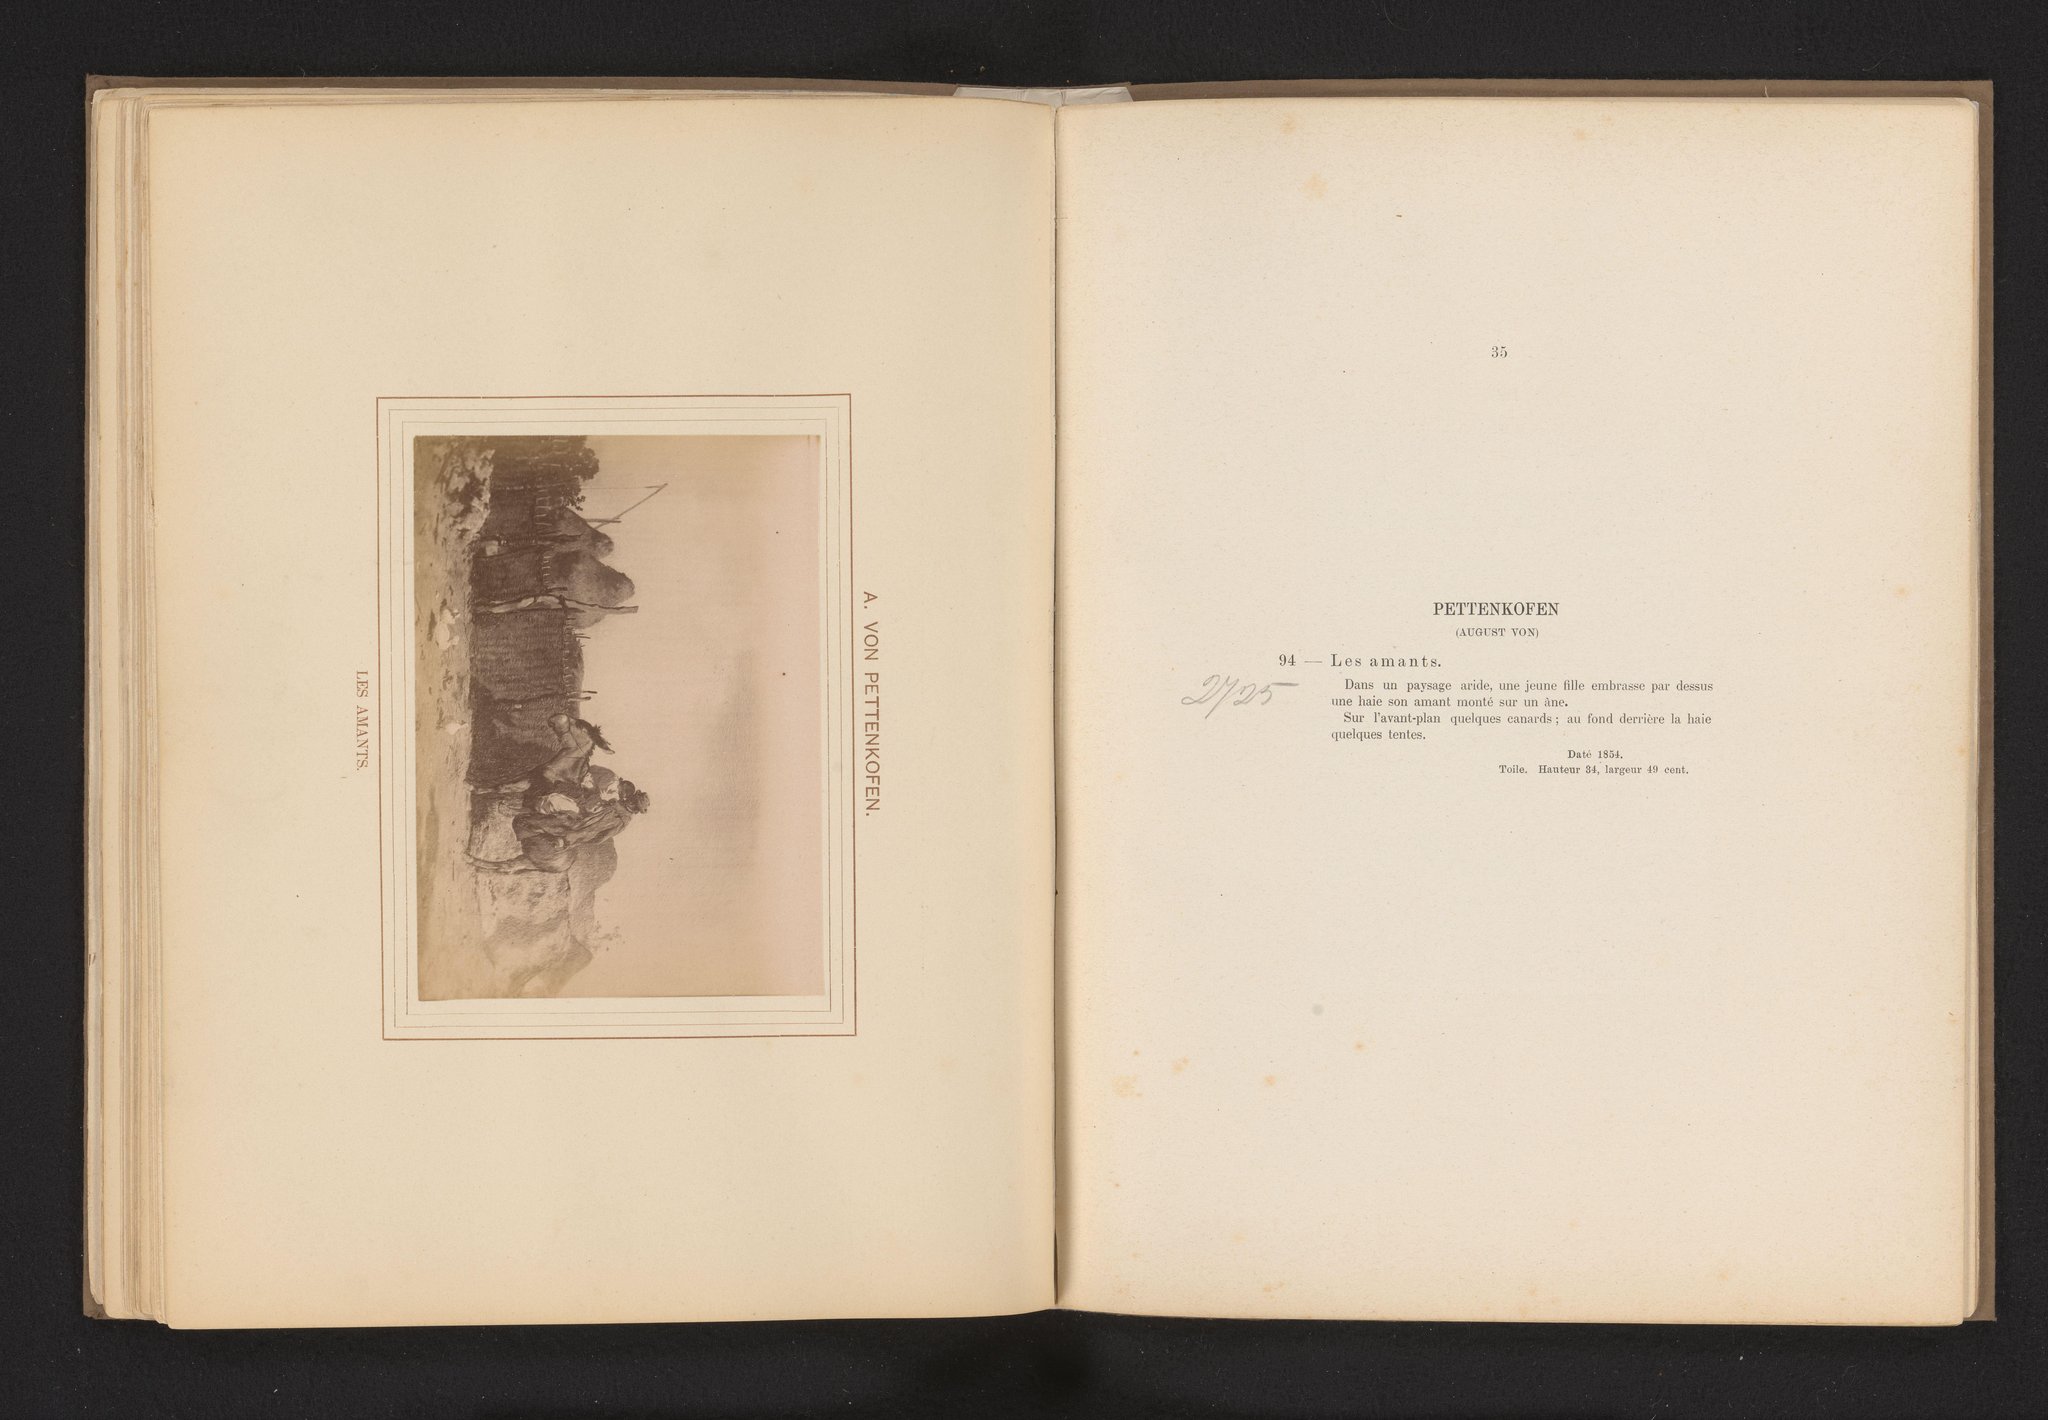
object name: page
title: Les amants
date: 1878-1883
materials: paper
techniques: albumen print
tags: riding a horse, ass, or mule; rider, horseman, (lovers) kissing each other, painting, drawing and the graphic arts